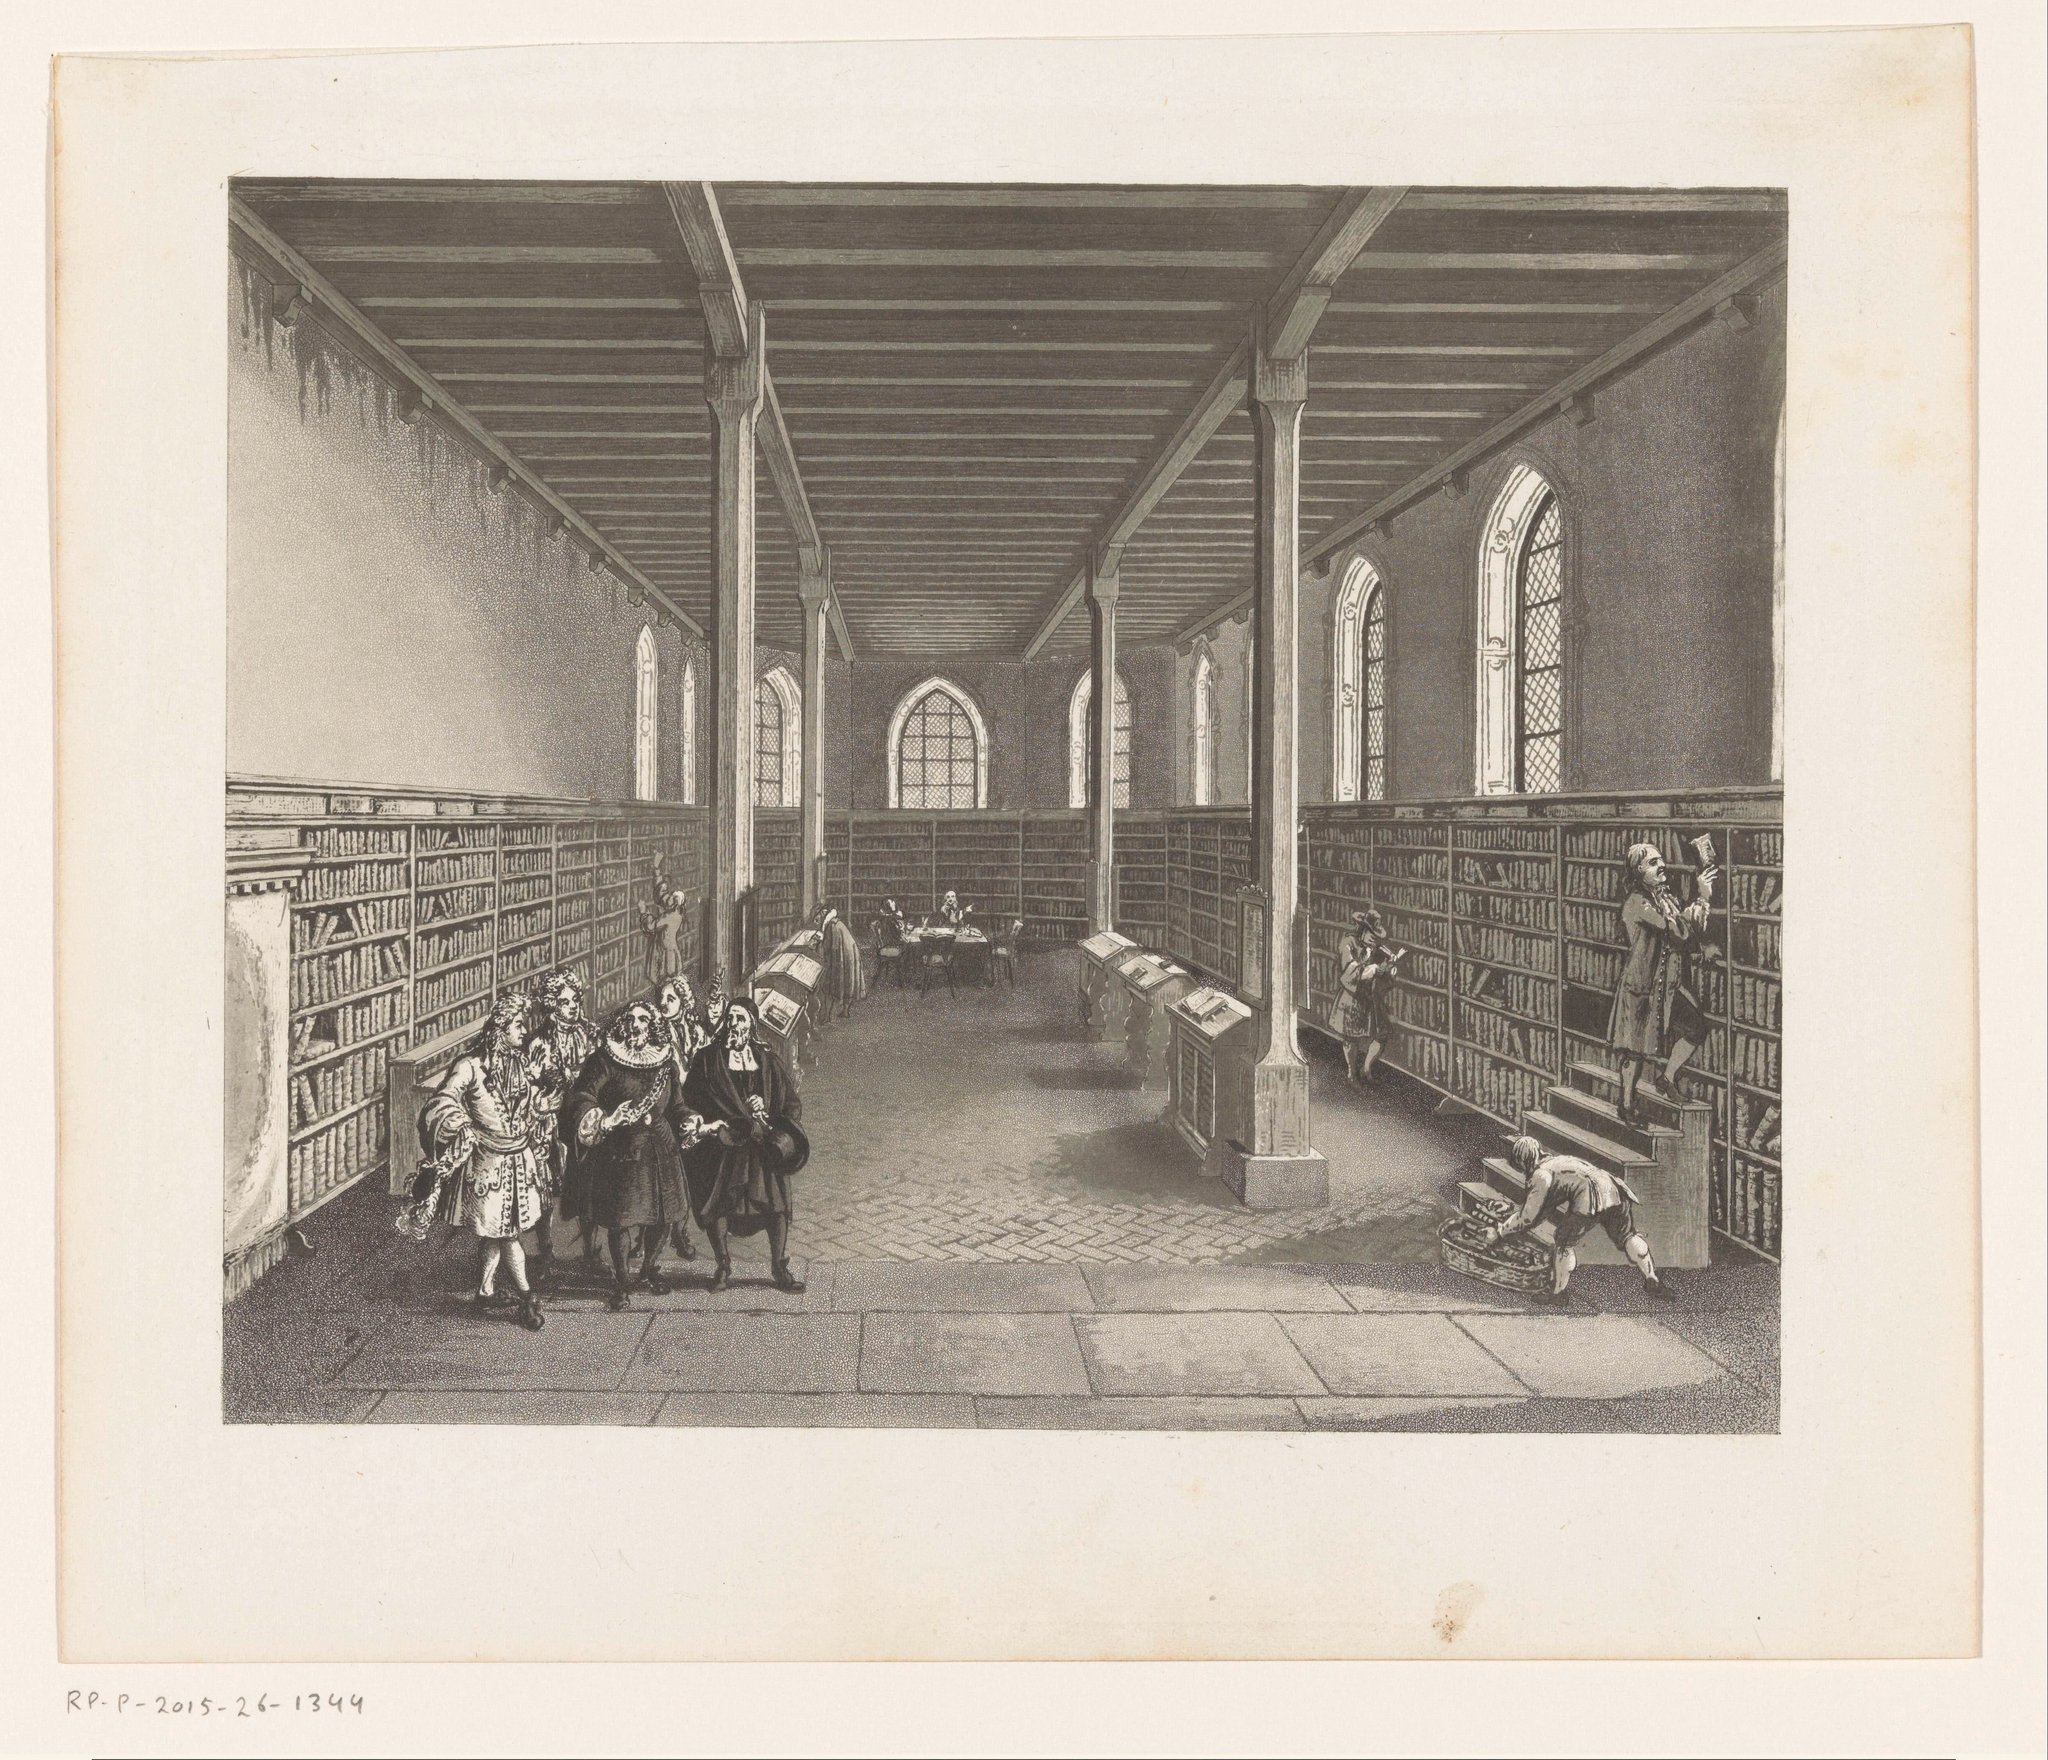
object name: book illustration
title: Interieur van de Wasserkirche te Zürich, 1673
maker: franz hegi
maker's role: draughtsman, painter, print maker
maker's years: 1774-1850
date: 1848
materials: paper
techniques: aquatint, etching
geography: zurich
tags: public library, lectern ~ reading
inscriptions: collector's mark: Lugt 4780, collector's mark: Lugt 2228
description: De kerk is opgedeeld in twee verdiepingen; deze prent toont de onderste verdieping die wordt gebruikt als bibliotheek. De wanden zijn bedekt met boekenkasten en in het midden staan zes lessenaars. Rechts plaatst een man op een trapje een boek terug in de kast.